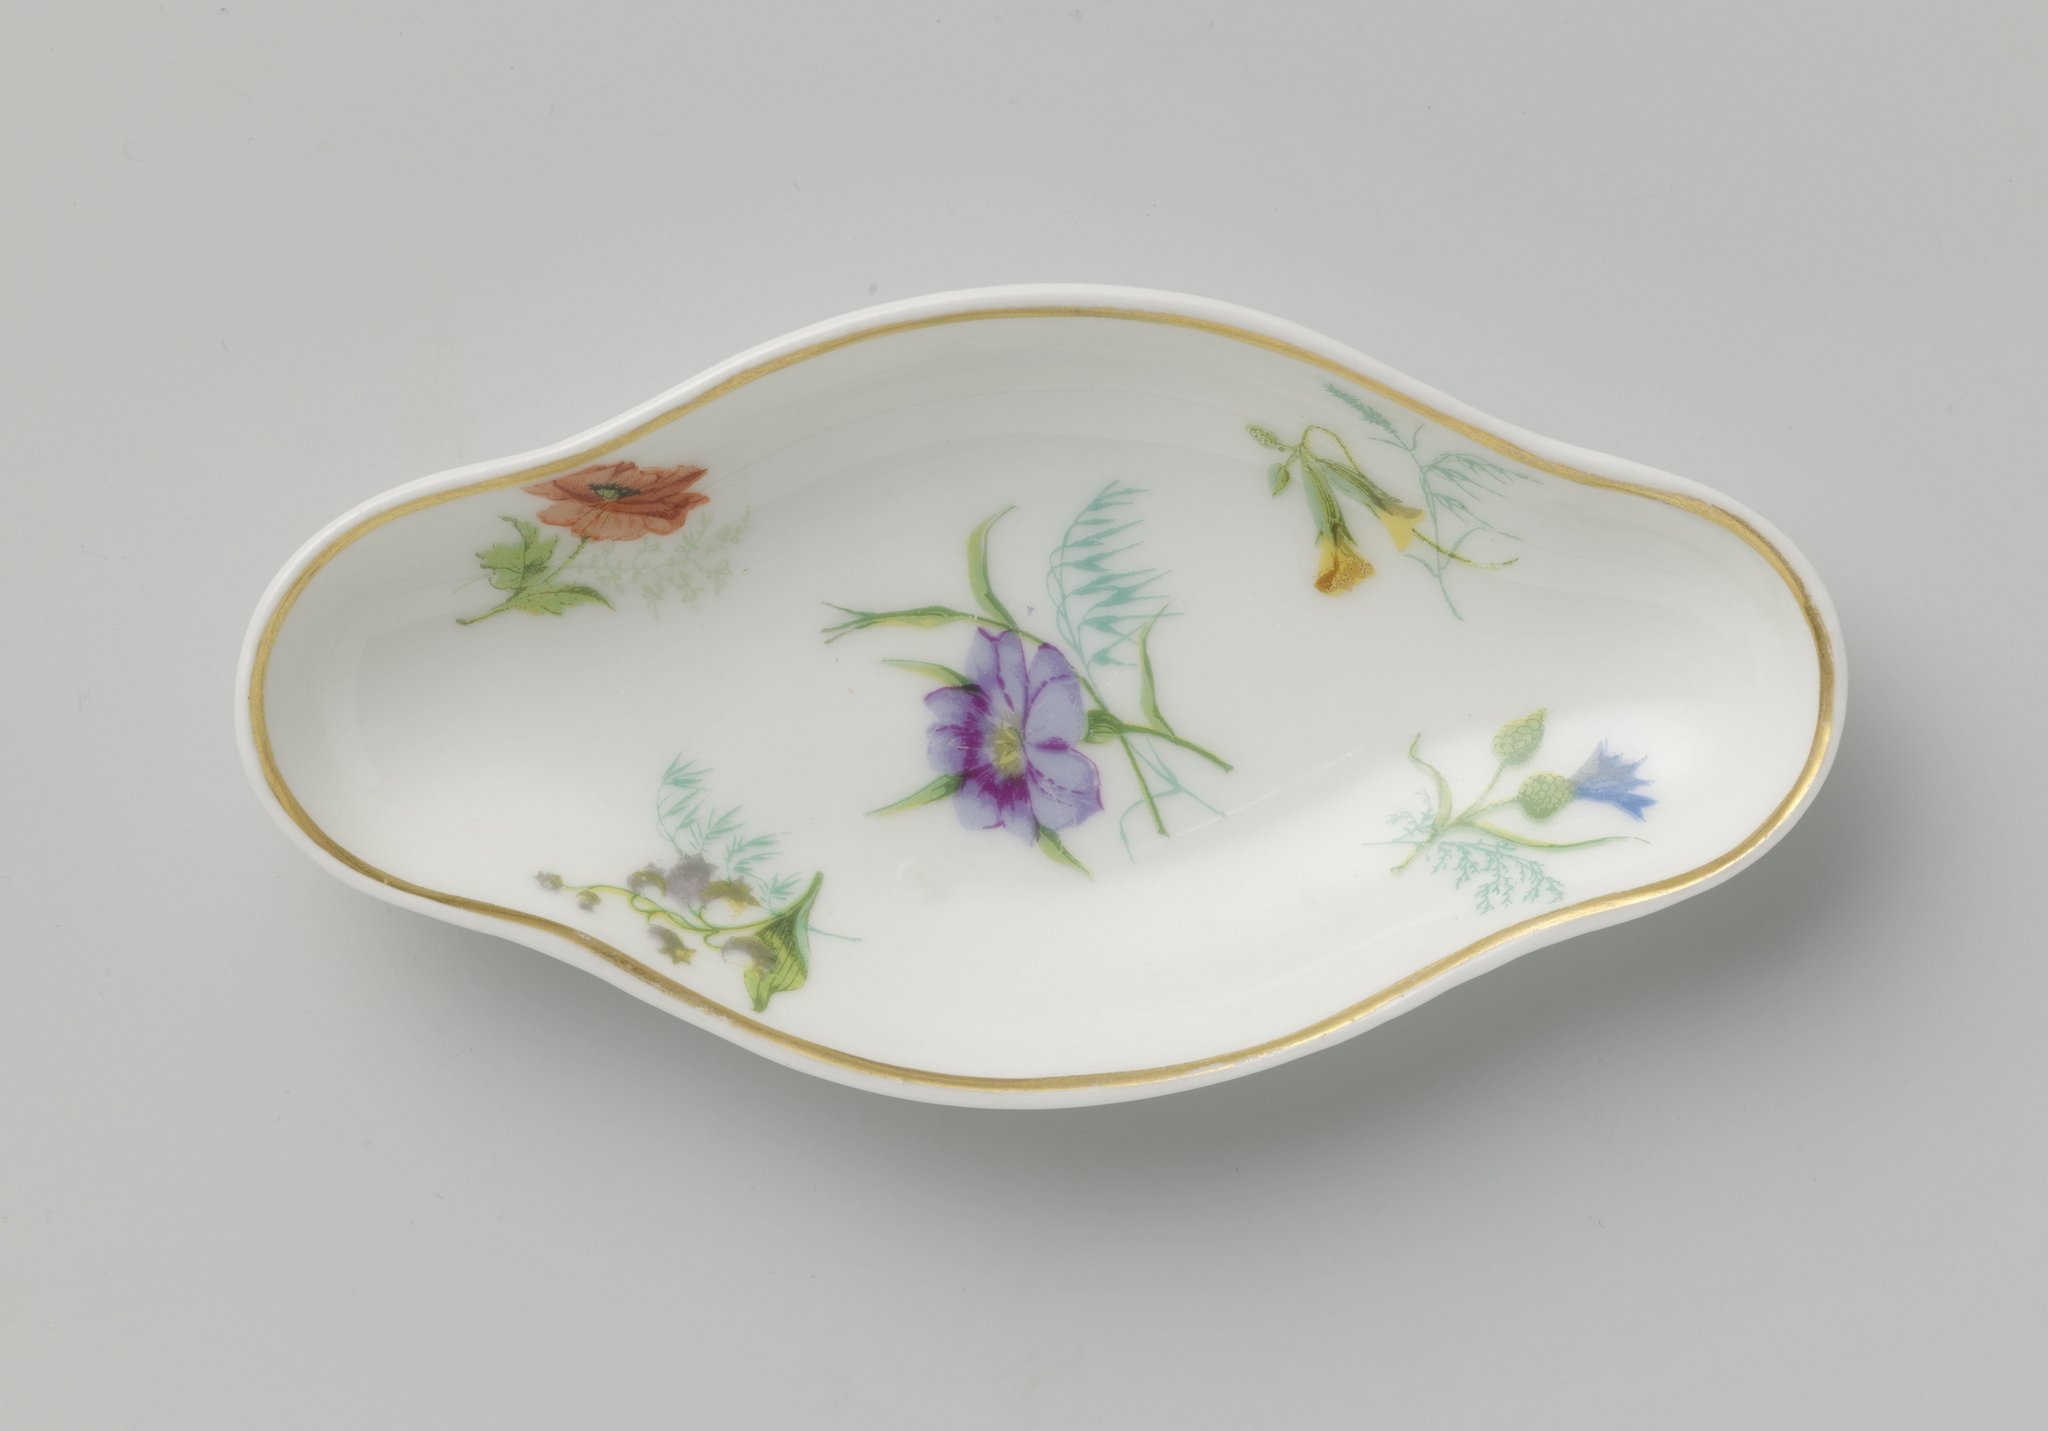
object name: toy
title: Dish with various flower sprays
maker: Anonymous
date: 1850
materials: glaze, gold, paint, porcelain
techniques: firing, forming, gilding, turning, vitrification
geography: france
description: Ovale, driemaal gelobde schaal van porselein, versierd op het glazuur met blauw, rood, roze, groen, geel, paars en goud. Op de voorzijde verschillende bloemtakken en een gouden lijn op de binnenrand.